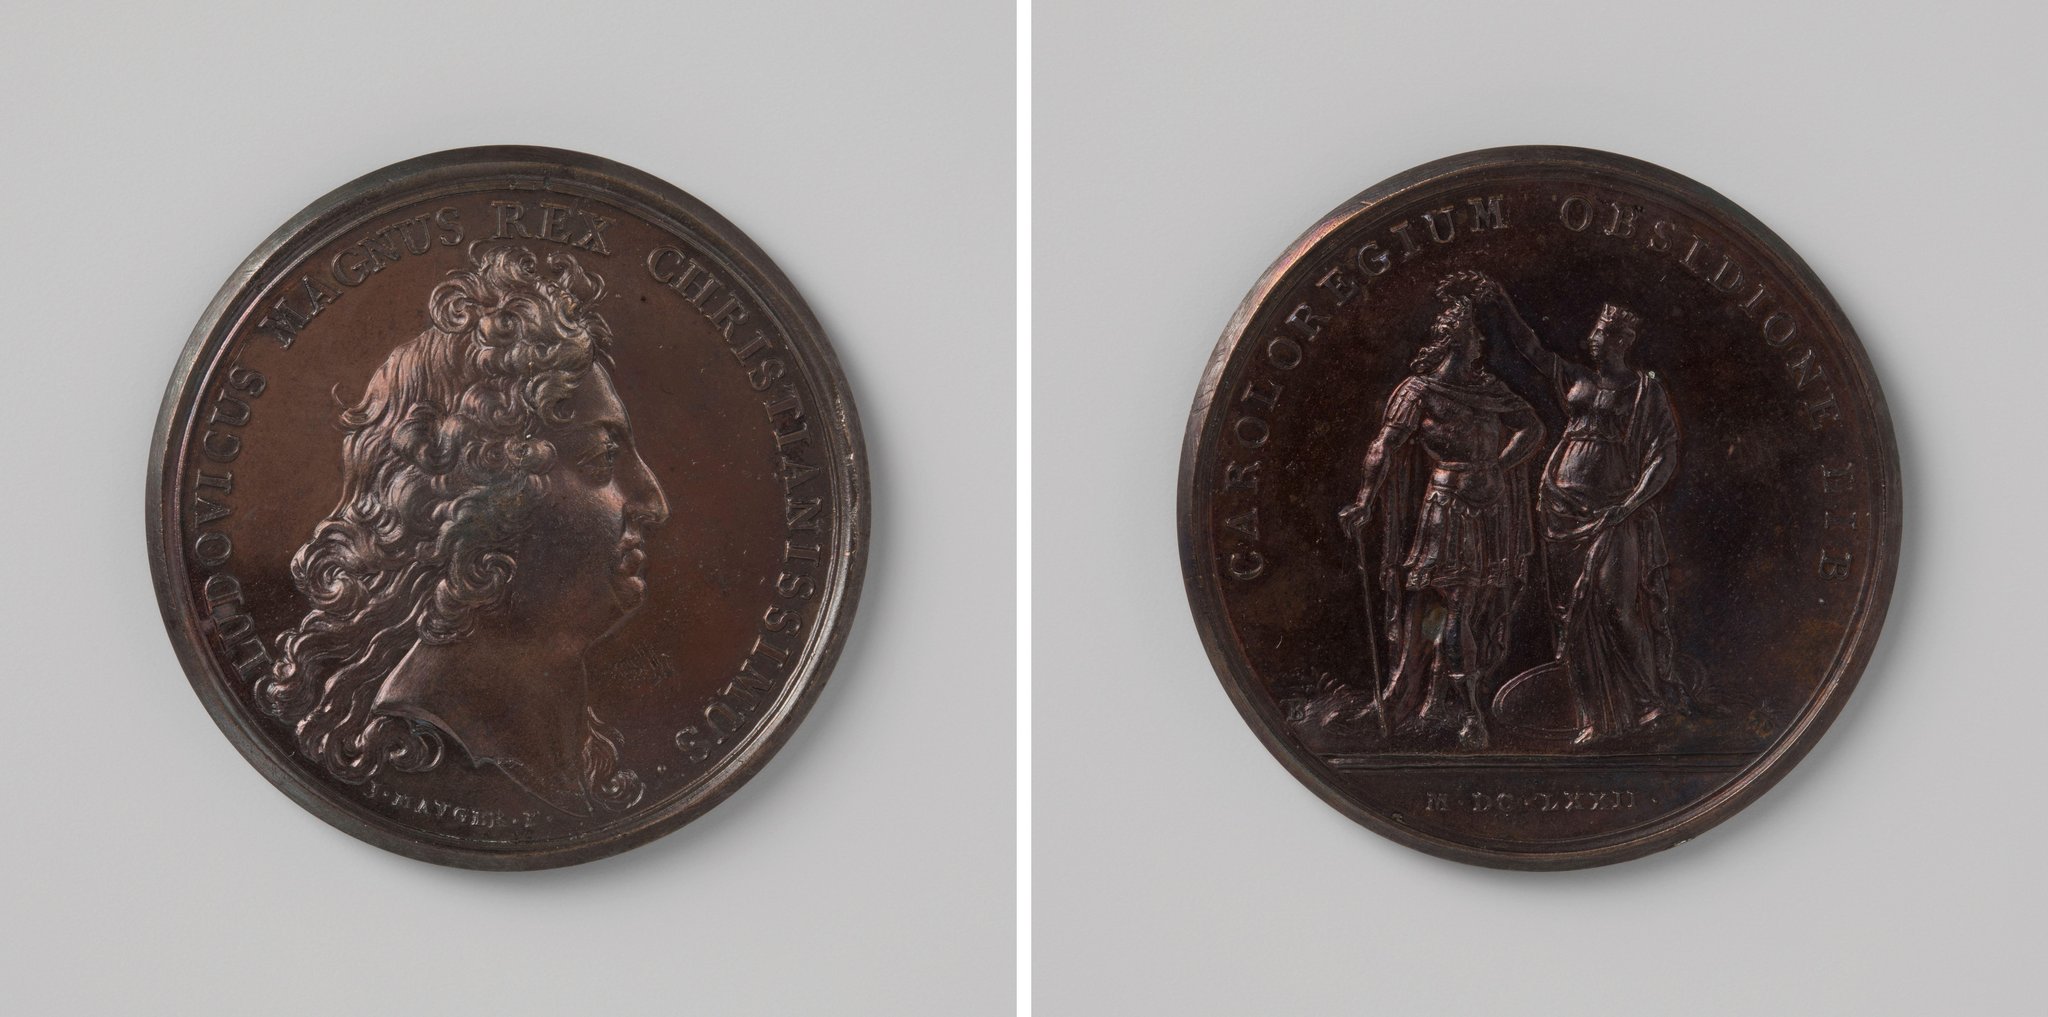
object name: history medal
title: Charleroi van het beleg verlost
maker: thomas bernard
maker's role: artist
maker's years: 1650-1713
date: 1699-1703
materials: bronze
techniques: striking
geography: paris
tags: lodewijk xiv (koning van frankrijk), rampjaar (disaster year)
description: Bronzen penning. Voorzijde: borststuk man (Lodewijk XIV) binnen omschrift. Keerzijde: gekroonde vrouw zet koning krans op hoofd.